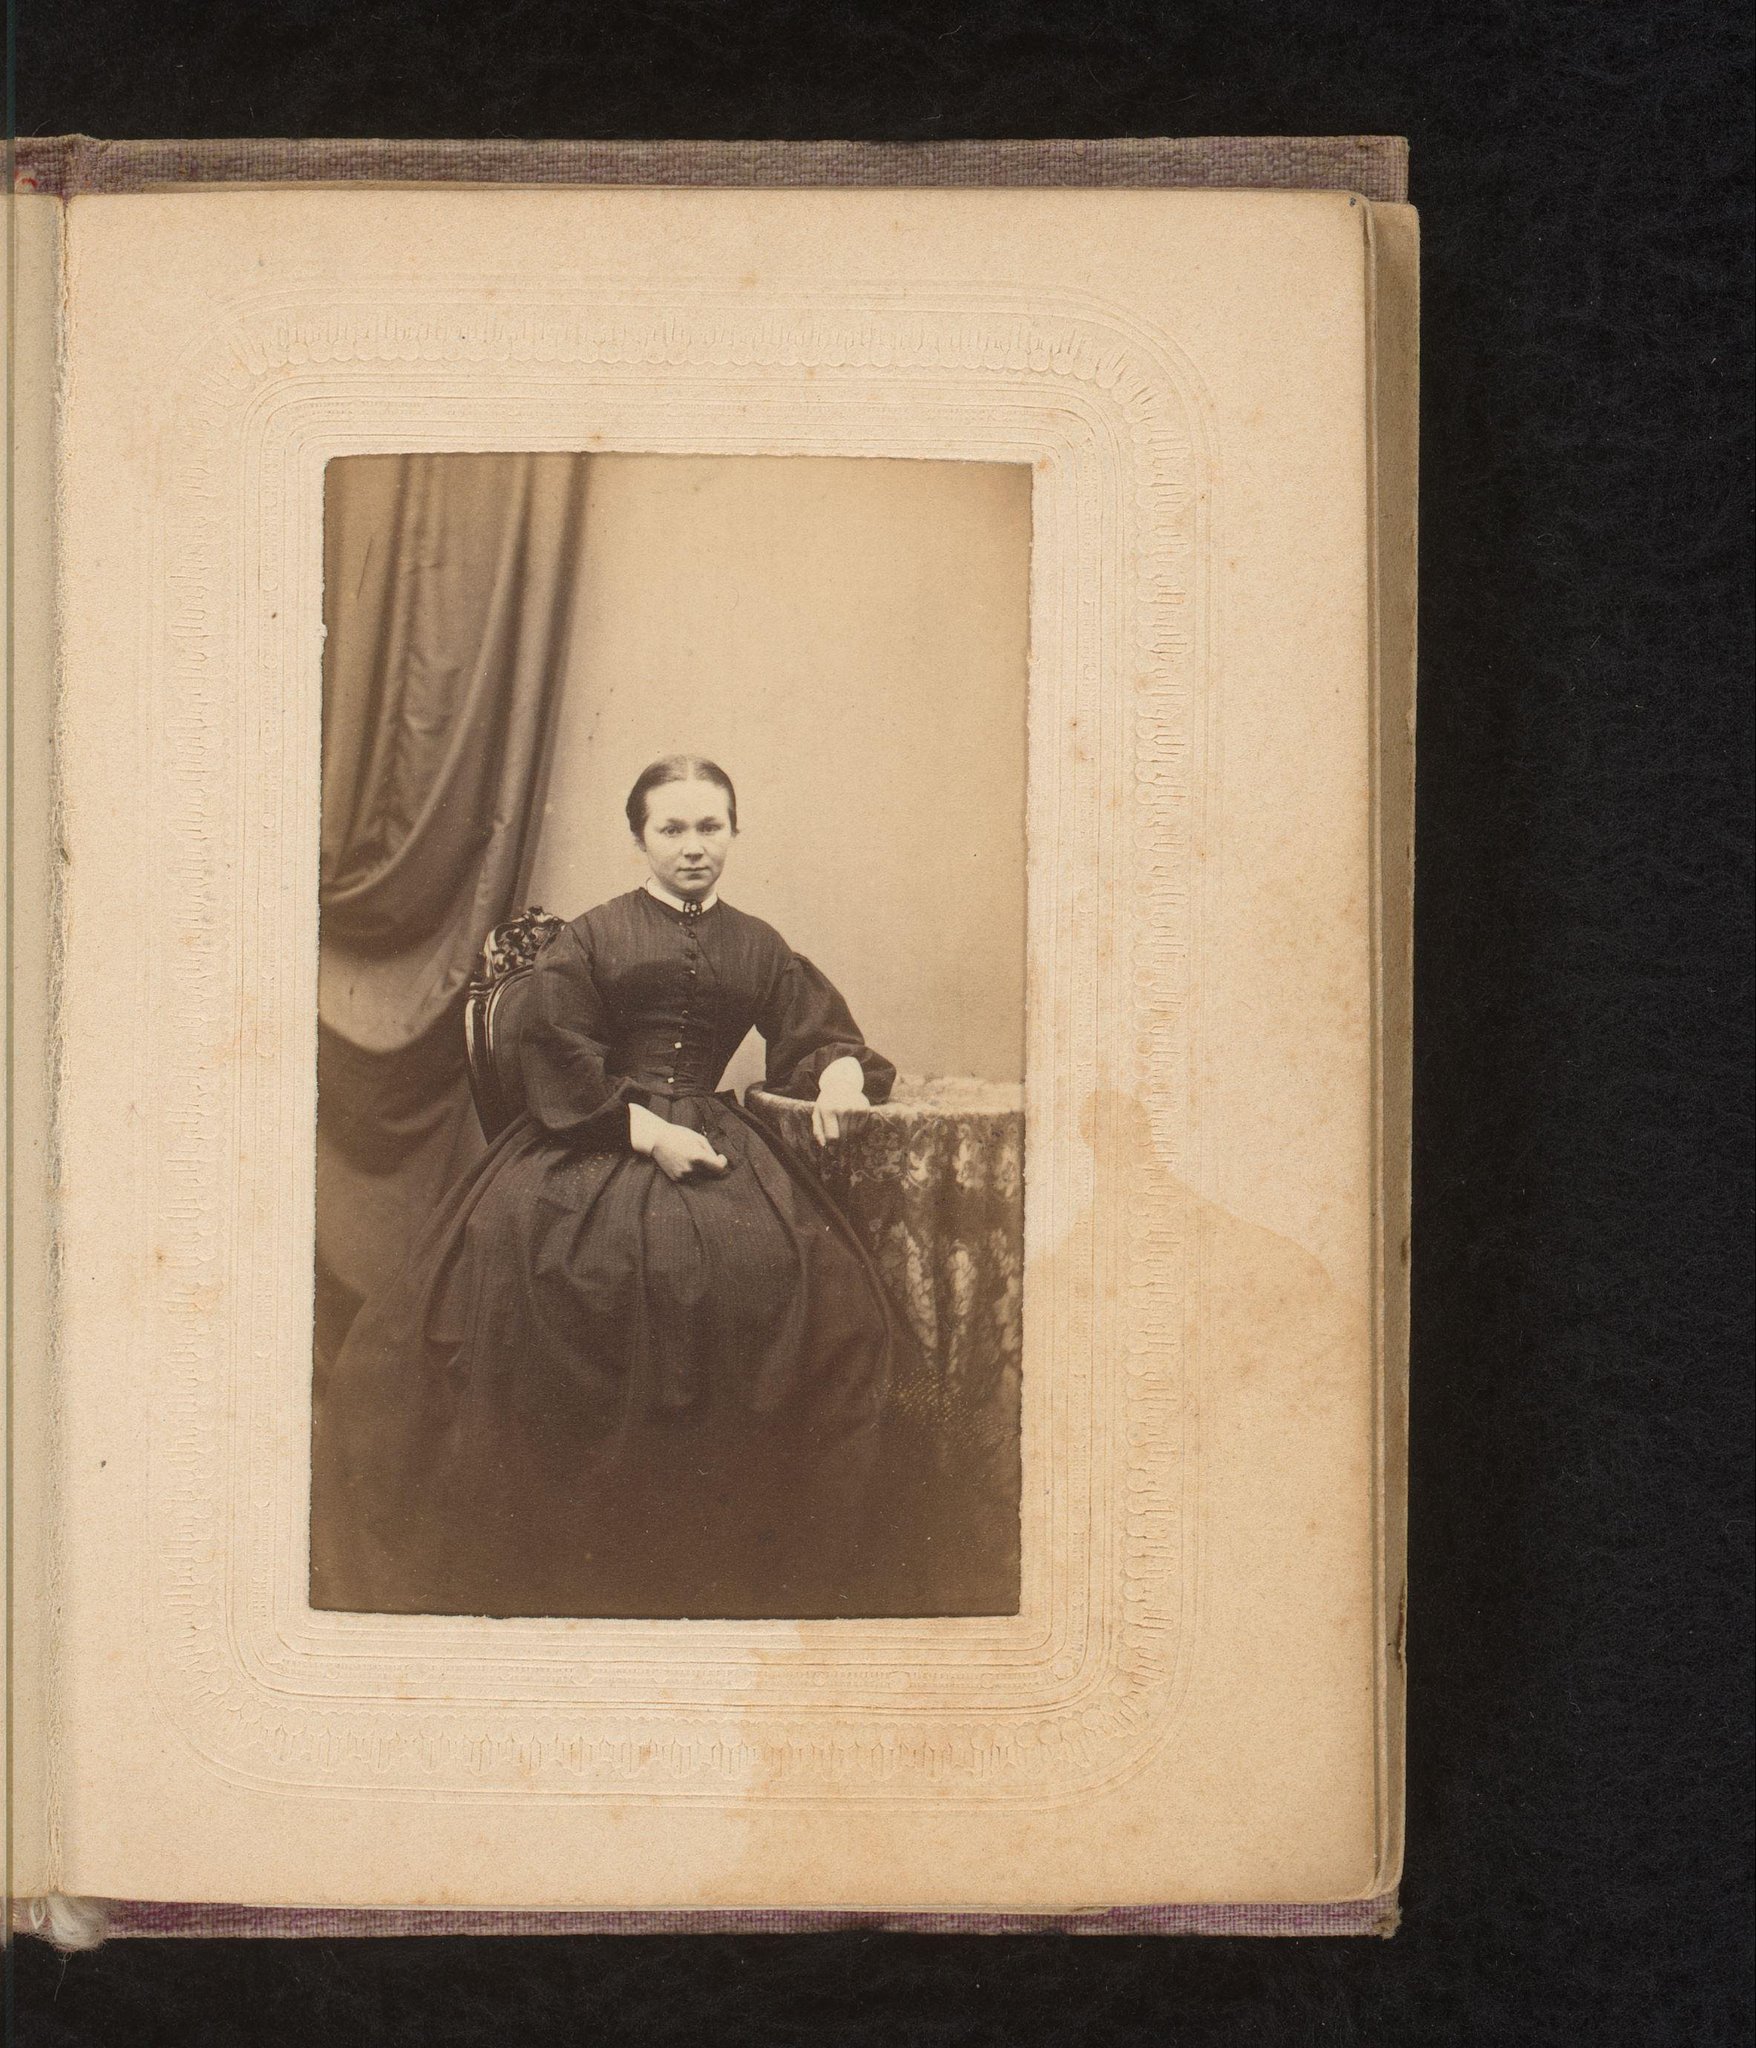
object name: album leaf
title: Portret van een vrouw, zittend aan een tafel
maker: k. moen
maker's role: fotograaf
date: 1860-1880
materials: cardboard, photographic support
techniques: albumen print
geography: zeist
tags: sitting figure - aa - female human figure, historical persons - bb - woman, table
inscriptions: inscription: ‘K. MOEN./ PHOTOGRAAF./ Zeijst.’